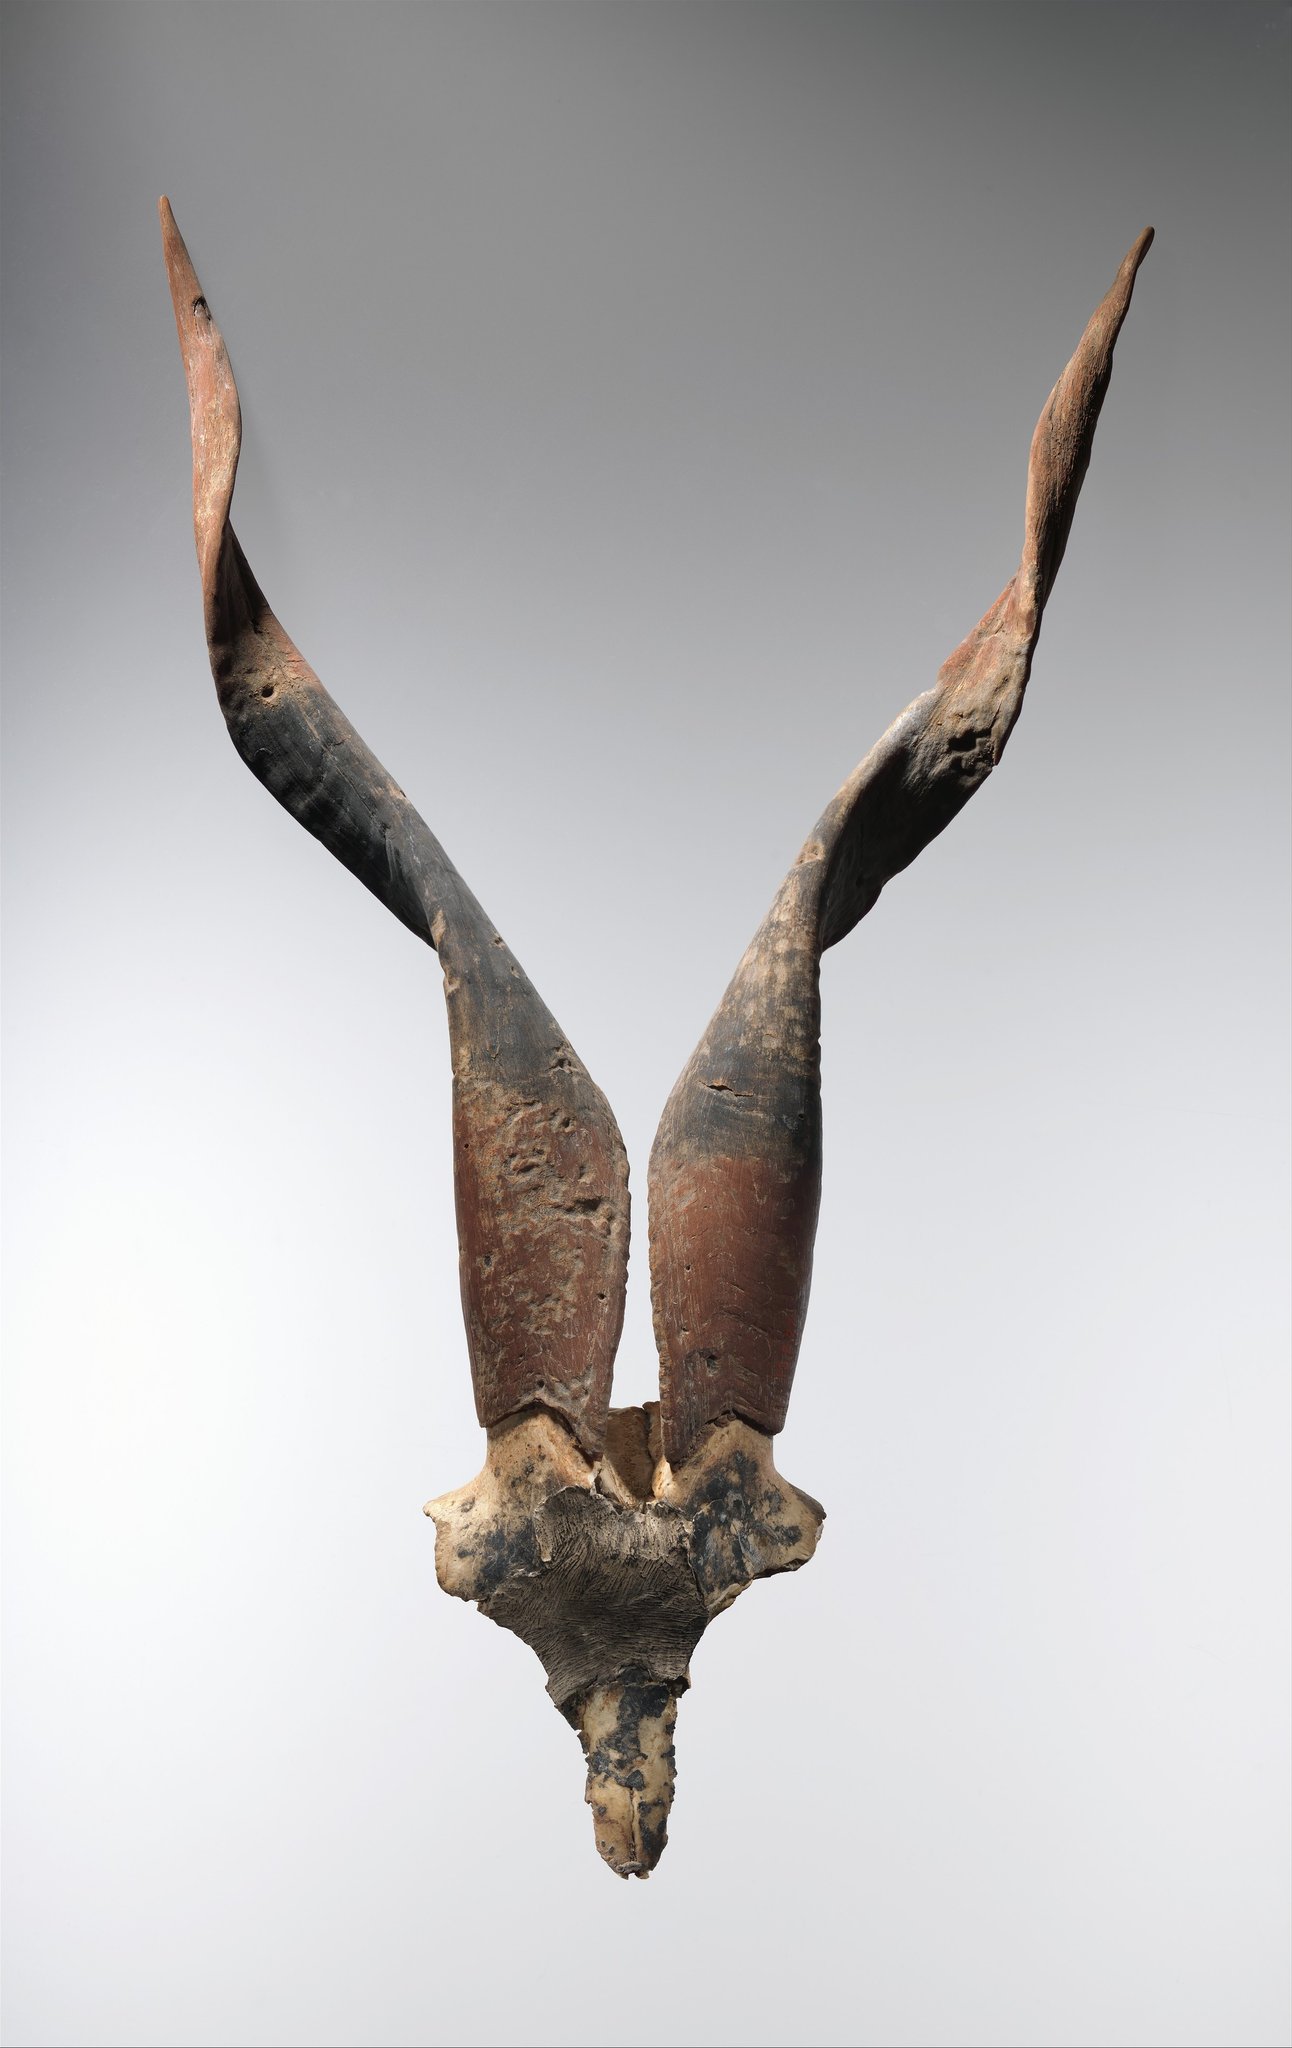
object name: bucranium, antler, horn, pan grave, medjayu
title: Bucranium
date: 1640-1550 BCE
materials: antler, bone, paint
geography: egypt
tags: animals,skulls